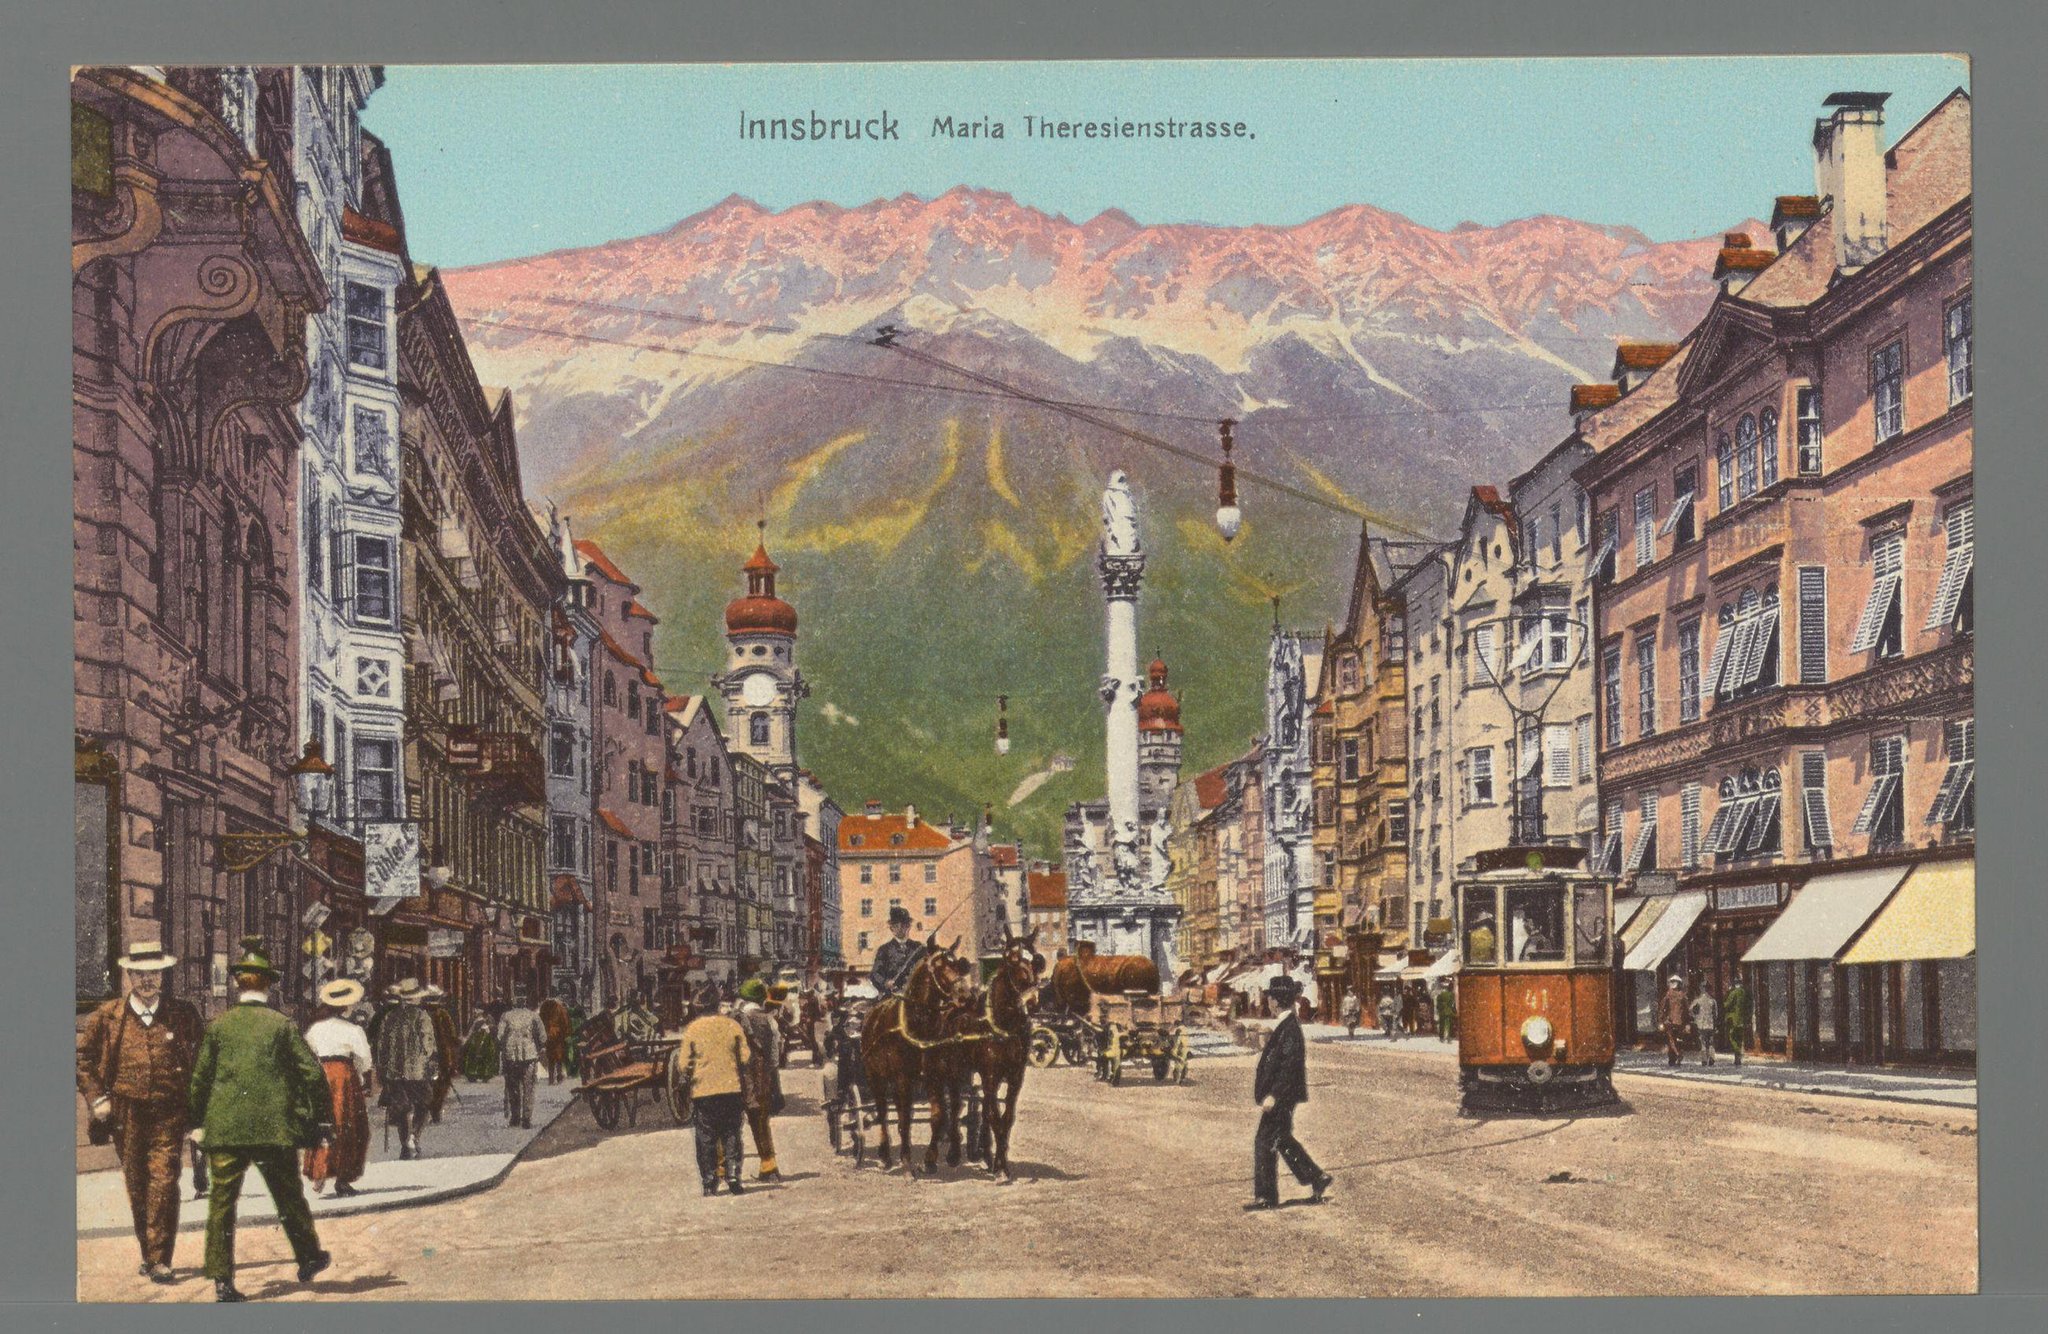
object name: photomechanical print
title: Innsbruck. Maria Theresienstrasse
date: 1904-1930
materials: cardboard, photographic process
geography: innsbruck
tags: street, mountains